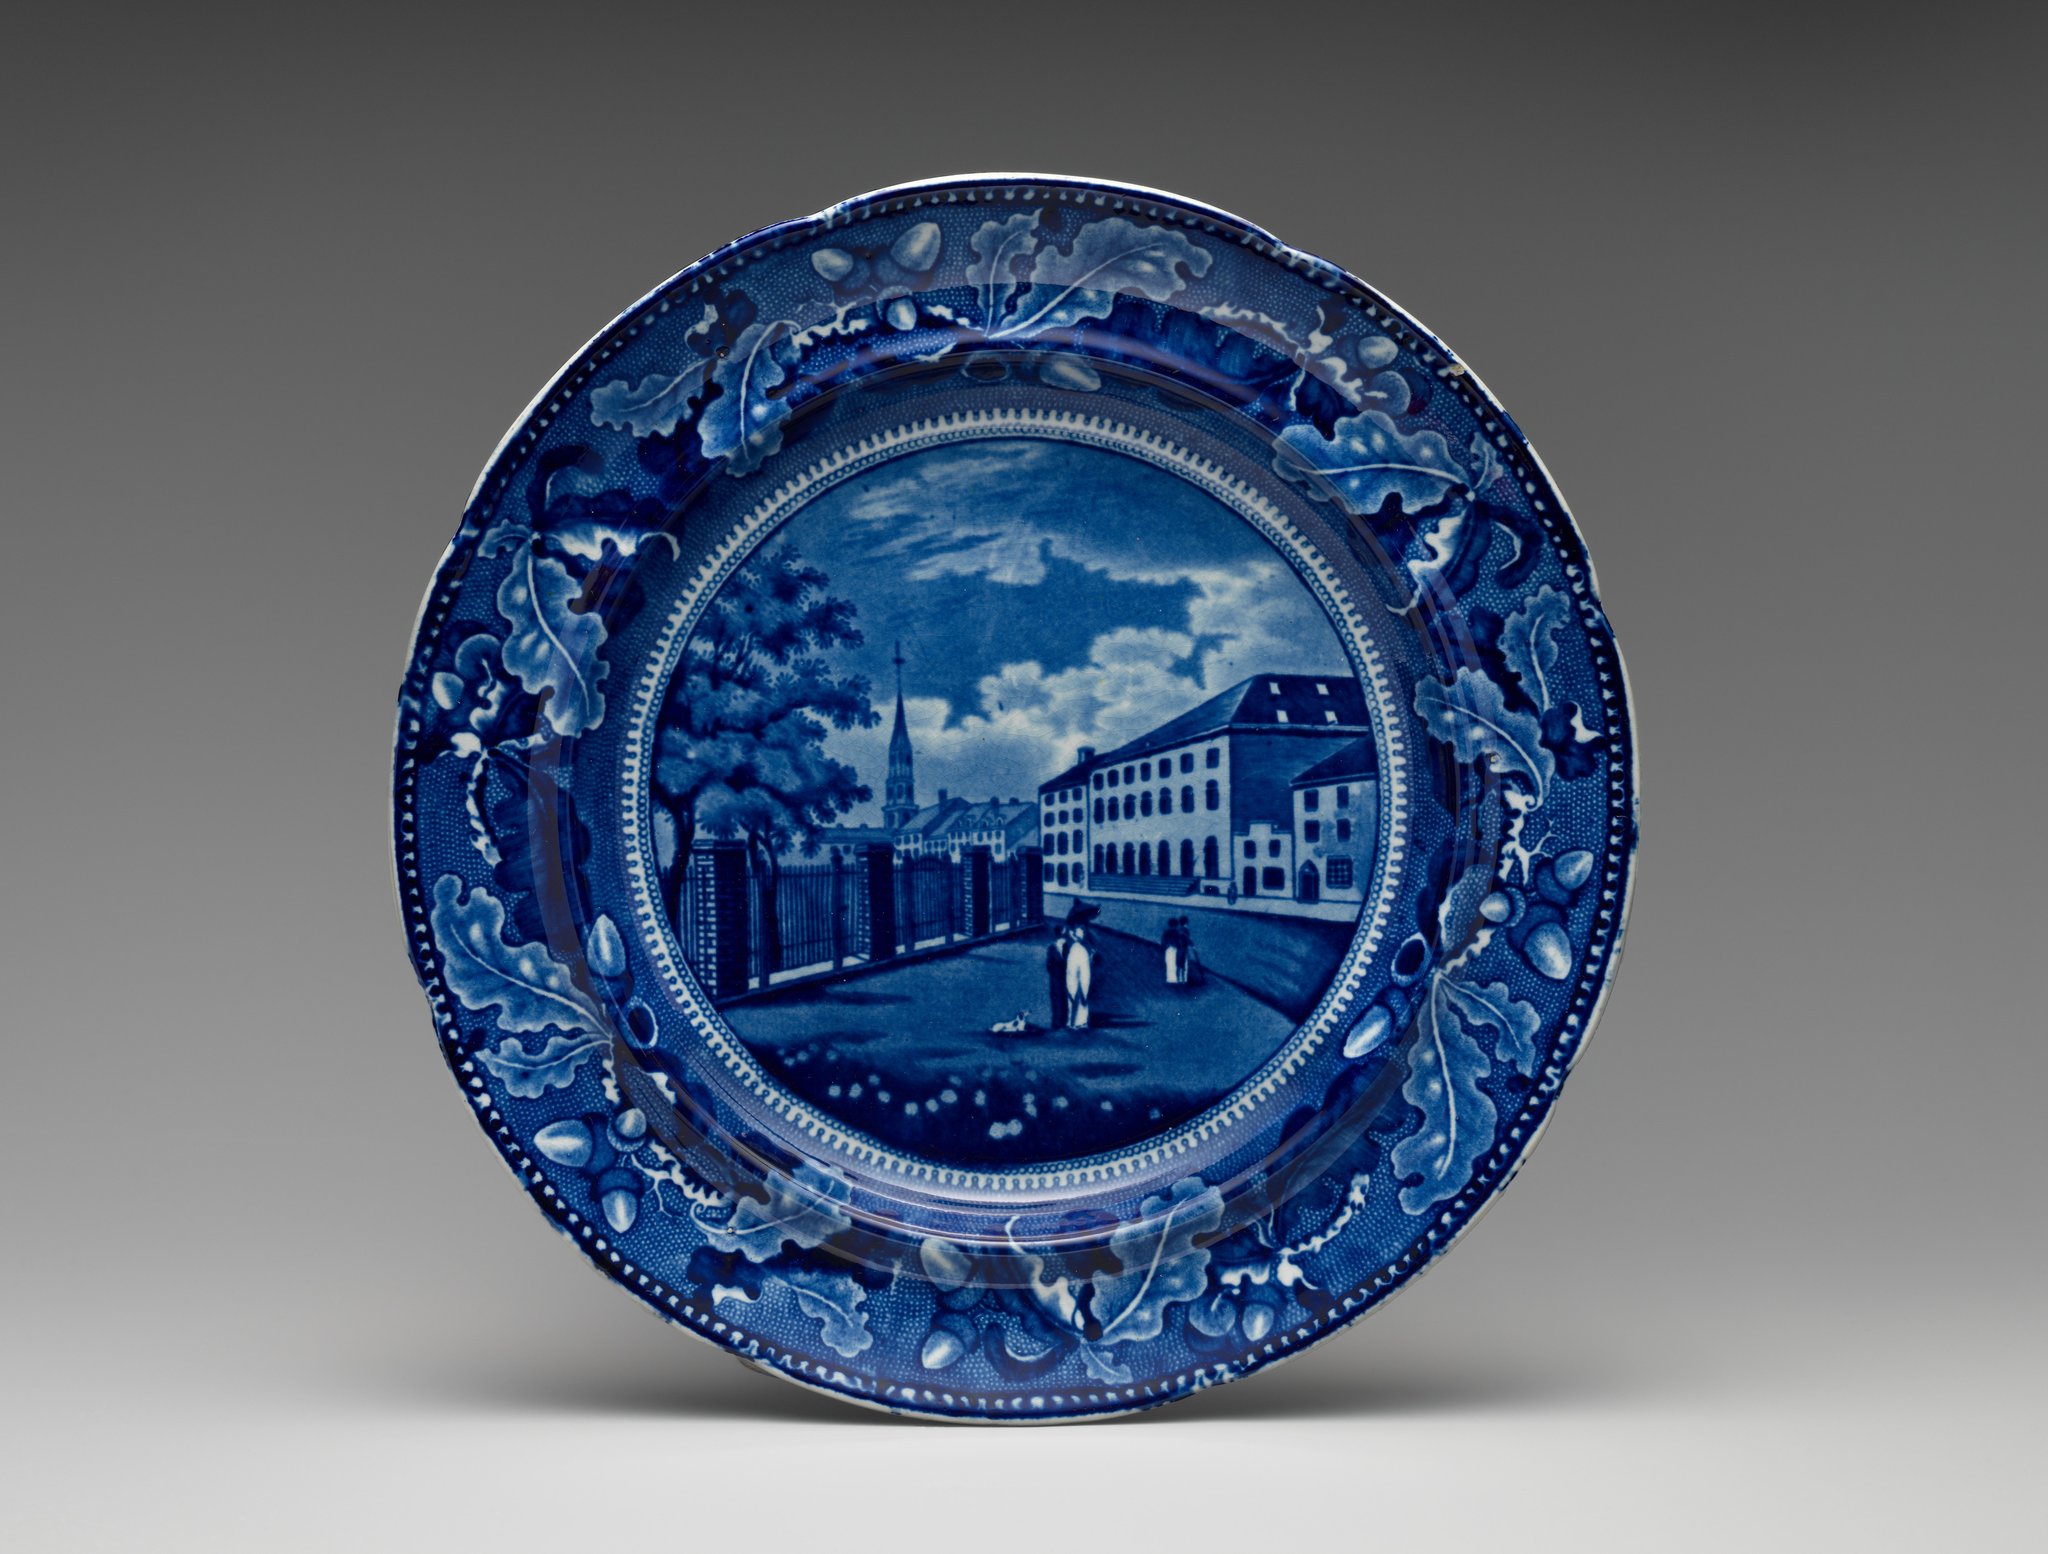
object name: plate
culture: british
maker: ralph stevenson & williams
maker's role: maker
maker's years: 1822-1827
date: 1825-1827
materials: earthenware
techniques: transfer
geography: england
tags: theatre